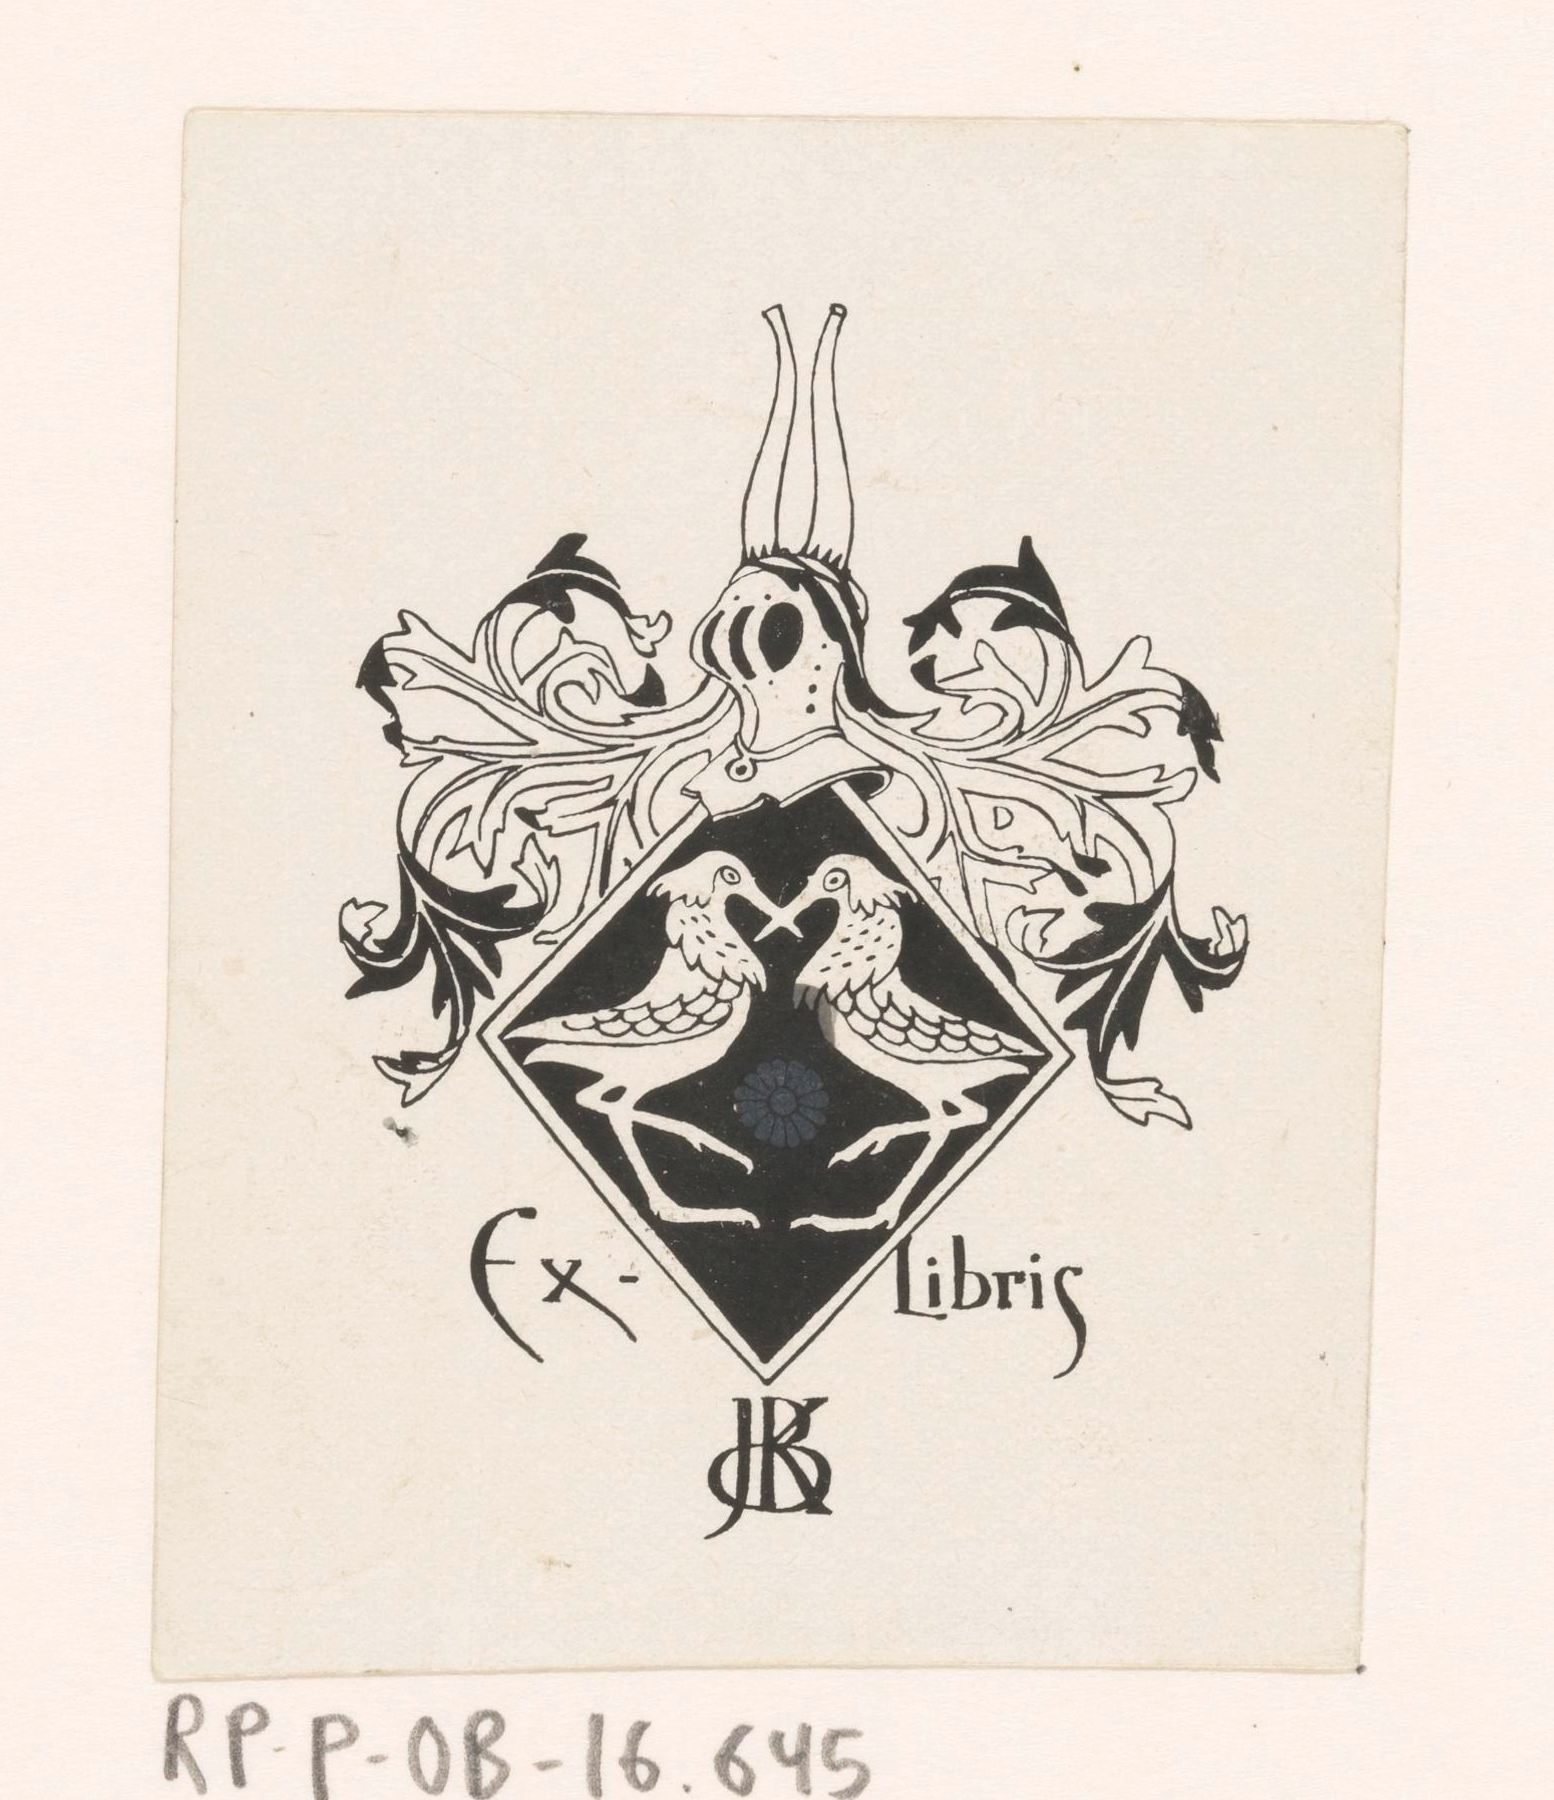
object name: print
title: Ex libris voor Jeltje de Bosch Kemper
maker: gerrit willem dijsselhof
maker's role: designer, draughtsman, print maker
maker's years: 1866-1924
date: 1900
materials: paper, watercolor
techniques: woodcut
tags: amsterdam, helmet, birds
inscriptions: collector's mark: Lugt 2228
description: Twee kemphanen in een ruit met daarop een helm waaruit bladeren ontspringen. Tussen de kemphanen een margriet.